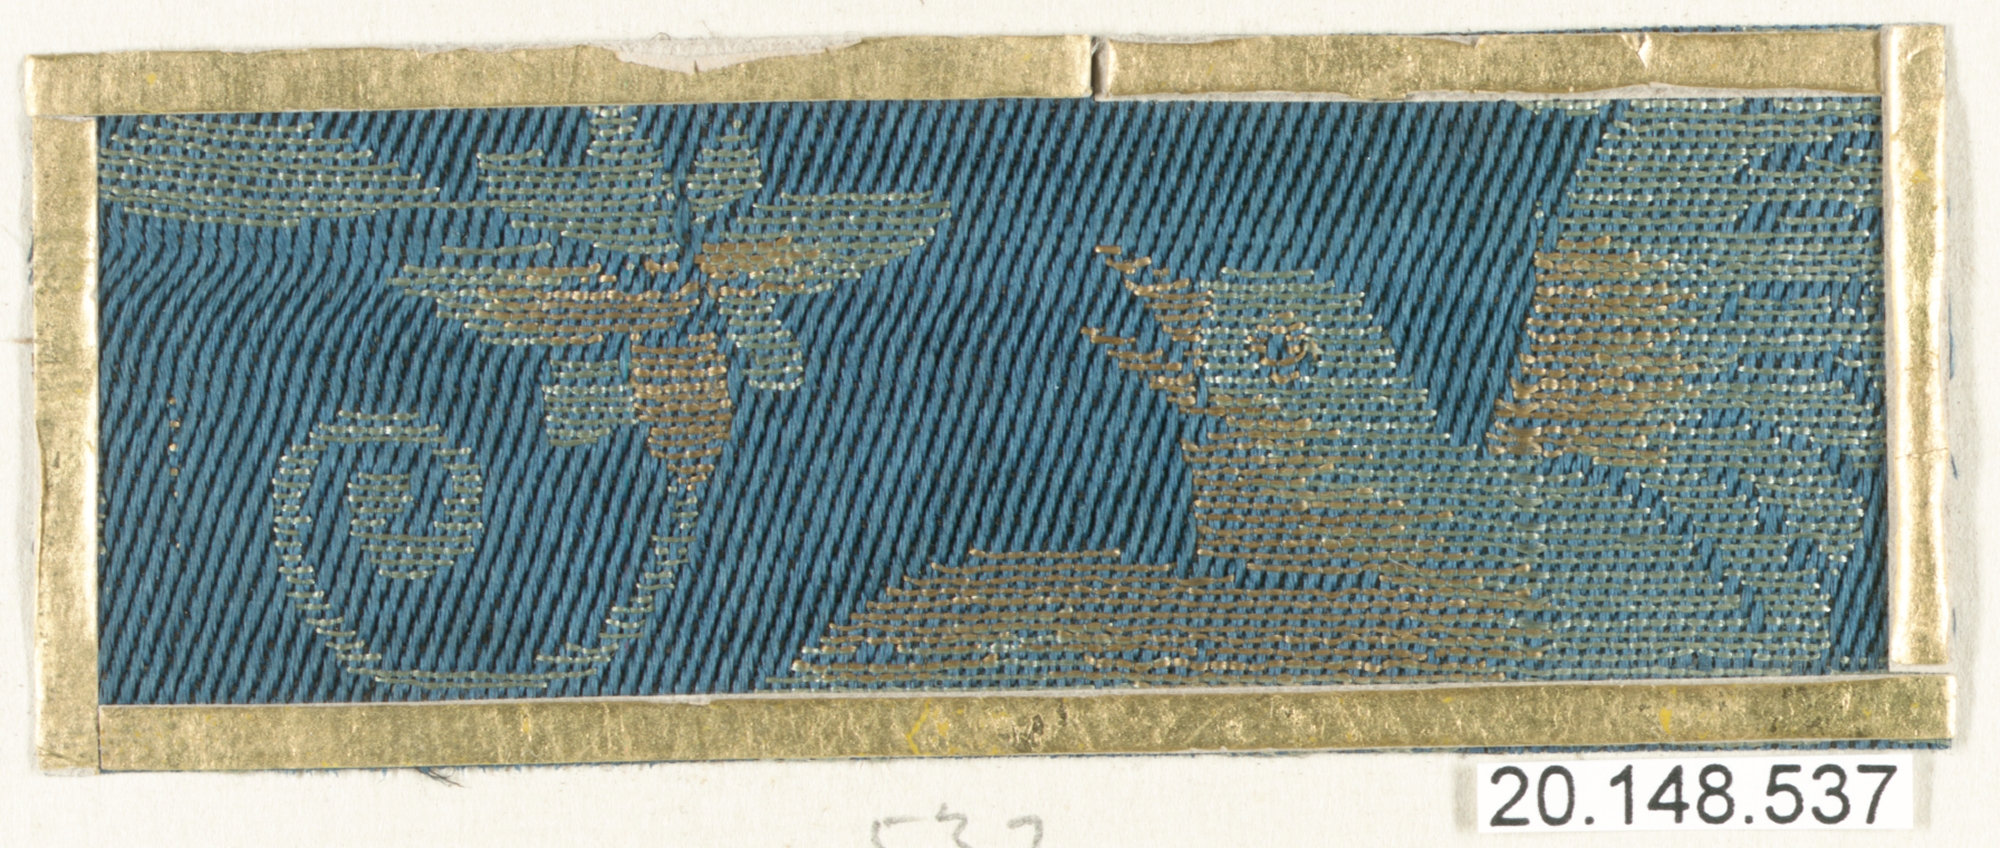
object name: piece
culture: japanese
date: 1701-1800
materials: silk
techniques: compound weave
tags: birds,flowers